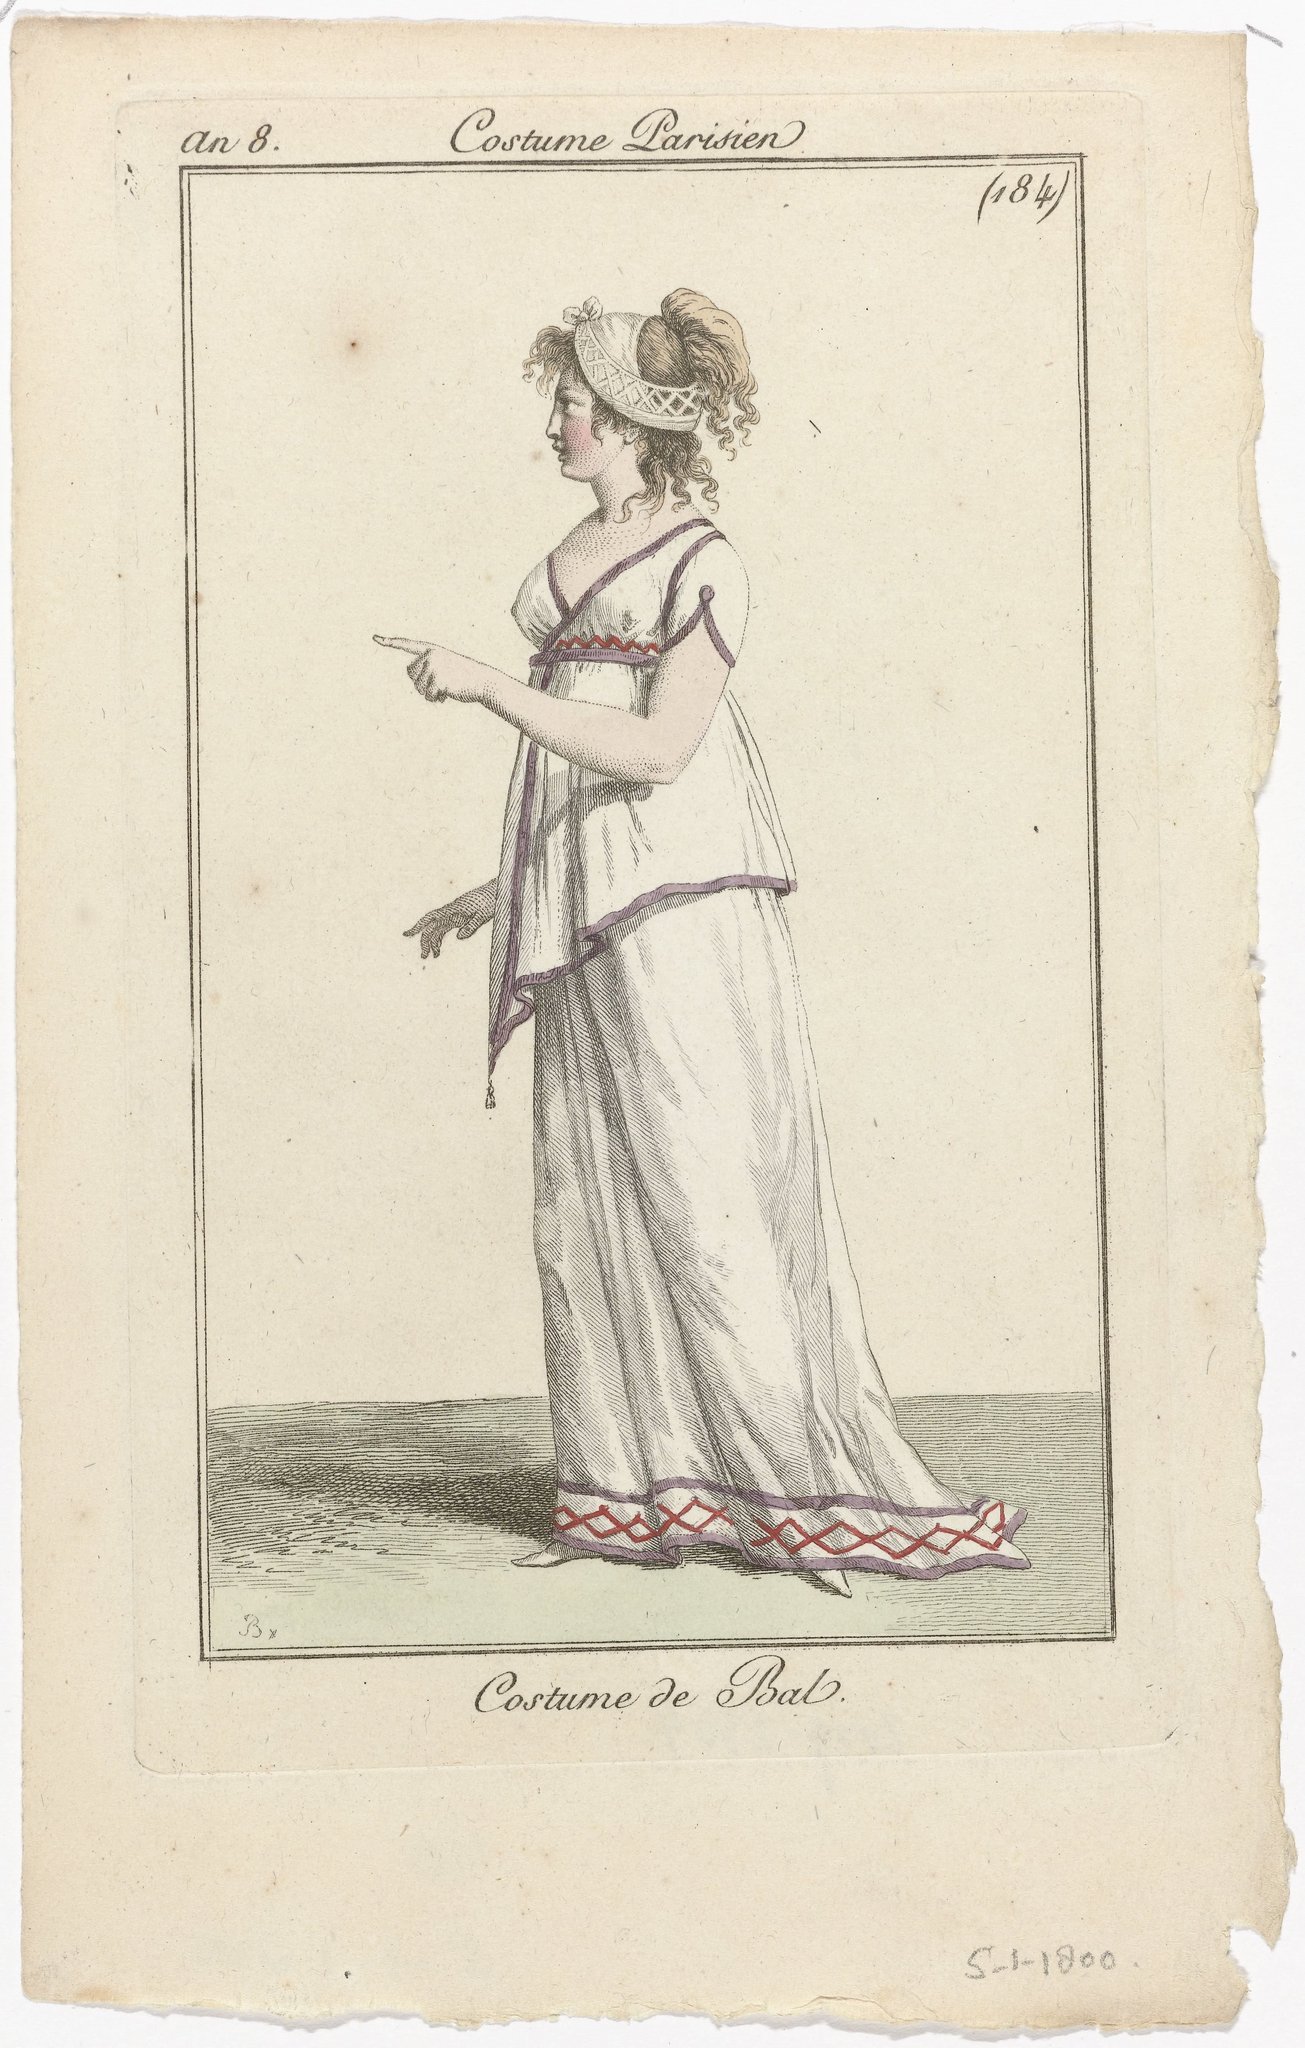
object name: fashion print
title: Journal des Dames et des Modes, Costume Parisien, 5 janvier 1800, (184) An 8 : Costume de Bal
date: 1800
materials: paper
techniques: engraving, hand coloring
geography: paris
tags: clothing for the upper part of the body (+ women's clothes), dress, gown: ball gown (+ women's clothes), clothing for the upper part of the body (tunic) (+ women's clothes), styles of hairdress - aa - ~ women, fashion plates, shoes, sandals (+ women's clothes), skirt (+ women's clothes)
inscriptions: title: ‘Costume Parisien’, caption: ‘Costume de Bal.’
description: Staande vrouw gekleed in een kostuum voor een bal. Asymmetrische tuniek met korte mouwen, overslag en punt met kwast. Rok met sleep, afgezet met een bies in contrasterende kleur en geometrisch patroon. Het opgestoken haar is versierd met een haarband of haarnet. platte schoenen met puntige neuzen. De prent maakt deel uit van het modetijdschrift Journal des Dames et des Modes, uitgegeven door Pierre de la Mésangère, Parijs, 1797-1839.